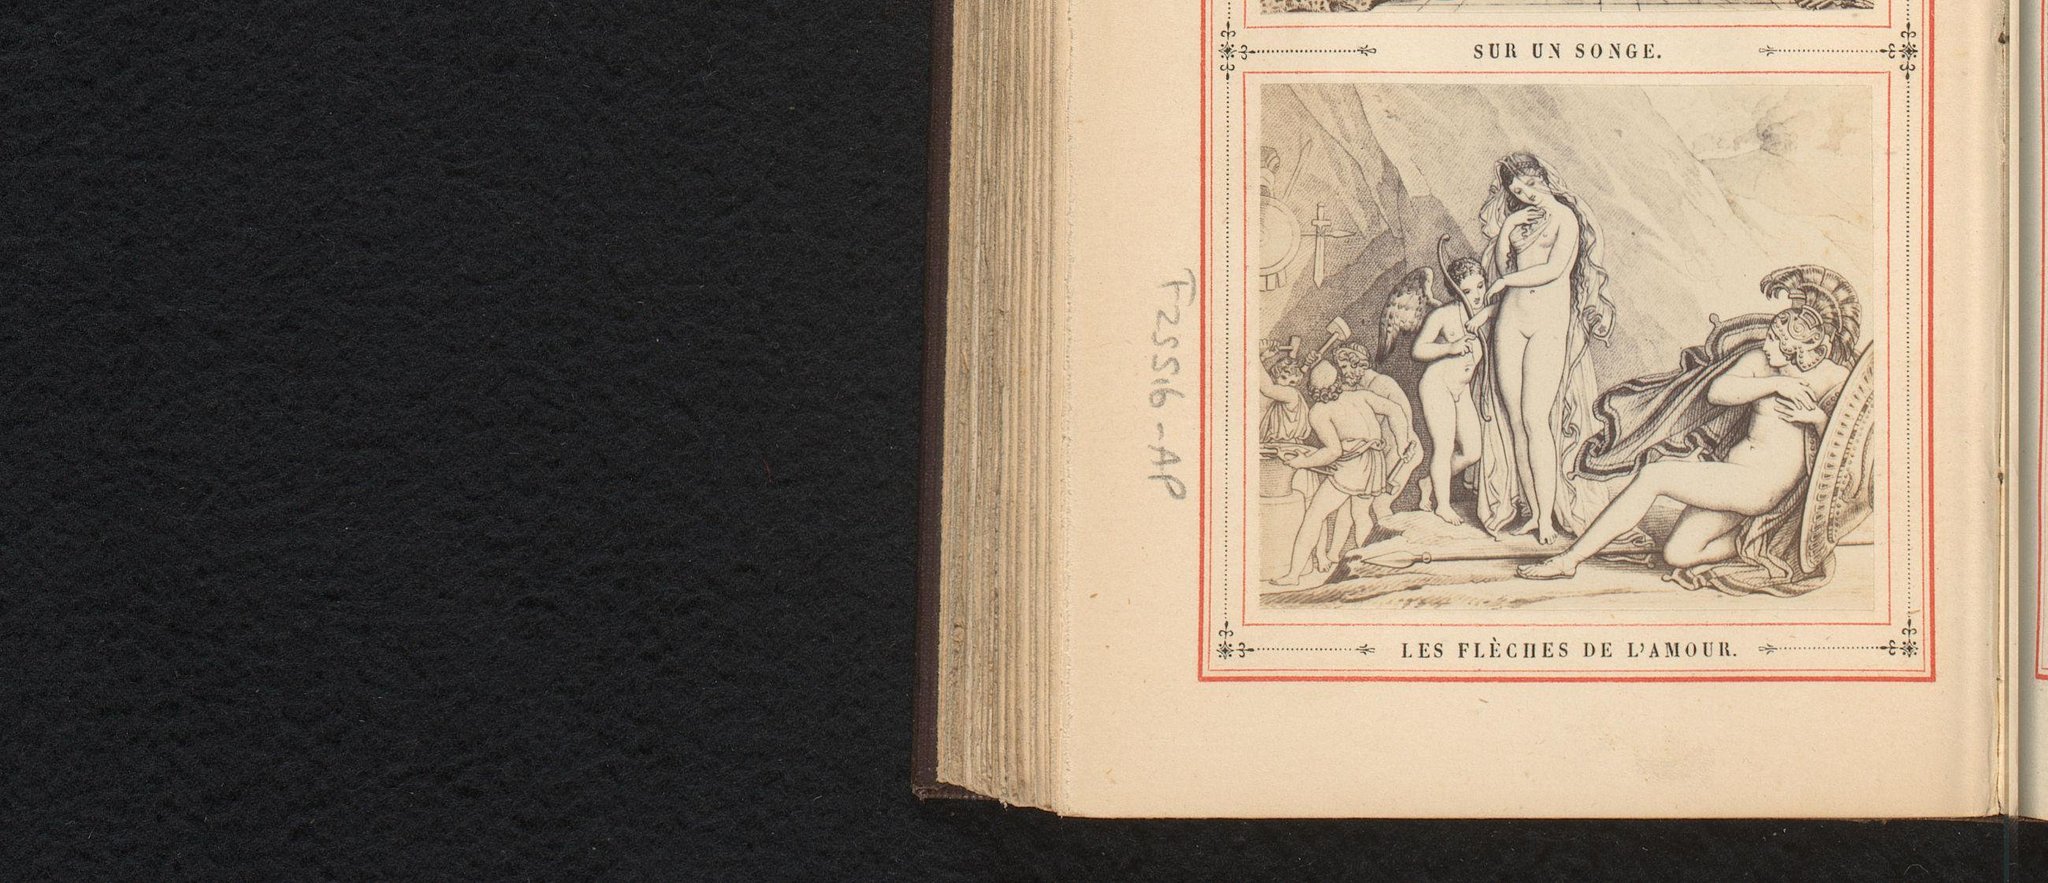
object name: page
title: Les flèches de l'amour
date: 1859-1864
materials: paper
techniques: albumen print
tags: gods ~ classical mythology